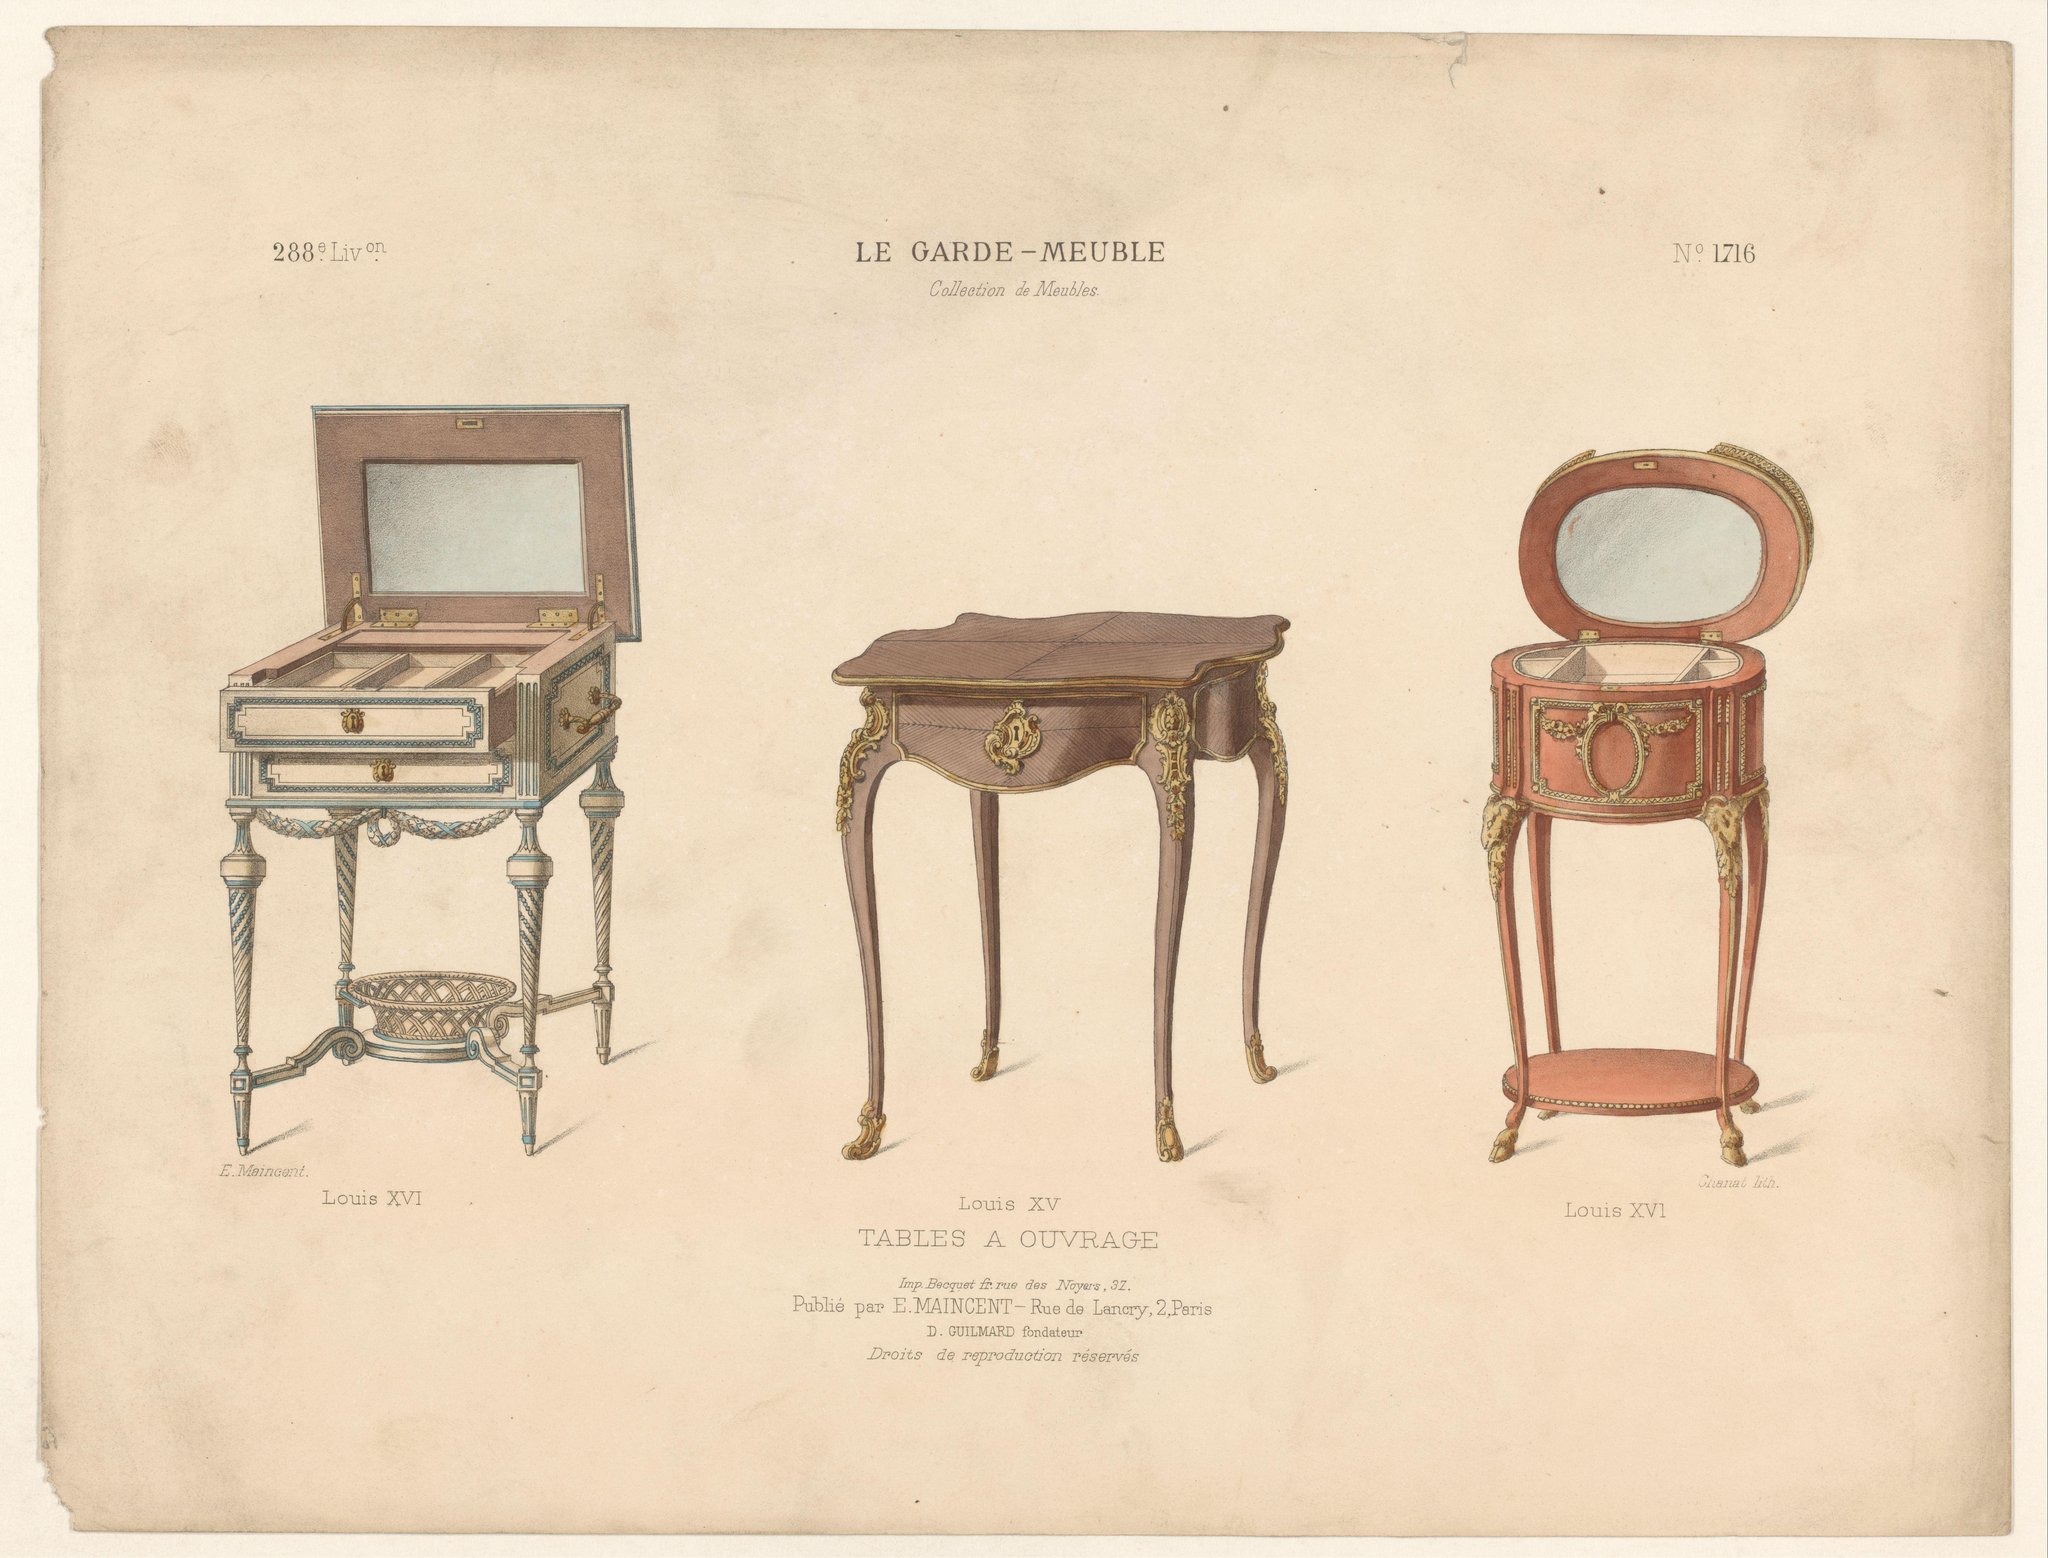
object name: print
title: Drie tafels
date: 1885-1895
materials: paper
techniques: hand coloring, lithograph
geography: paris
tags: table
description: Ieder Livraison in de serie Le Garde-Meuble bevat negen platen: drie 'sièges' (zitmeubels), drie 'meubles' (diverse meubels zoals tafels en kasten) en drie 'tentures' (gordijnen en draperieën).